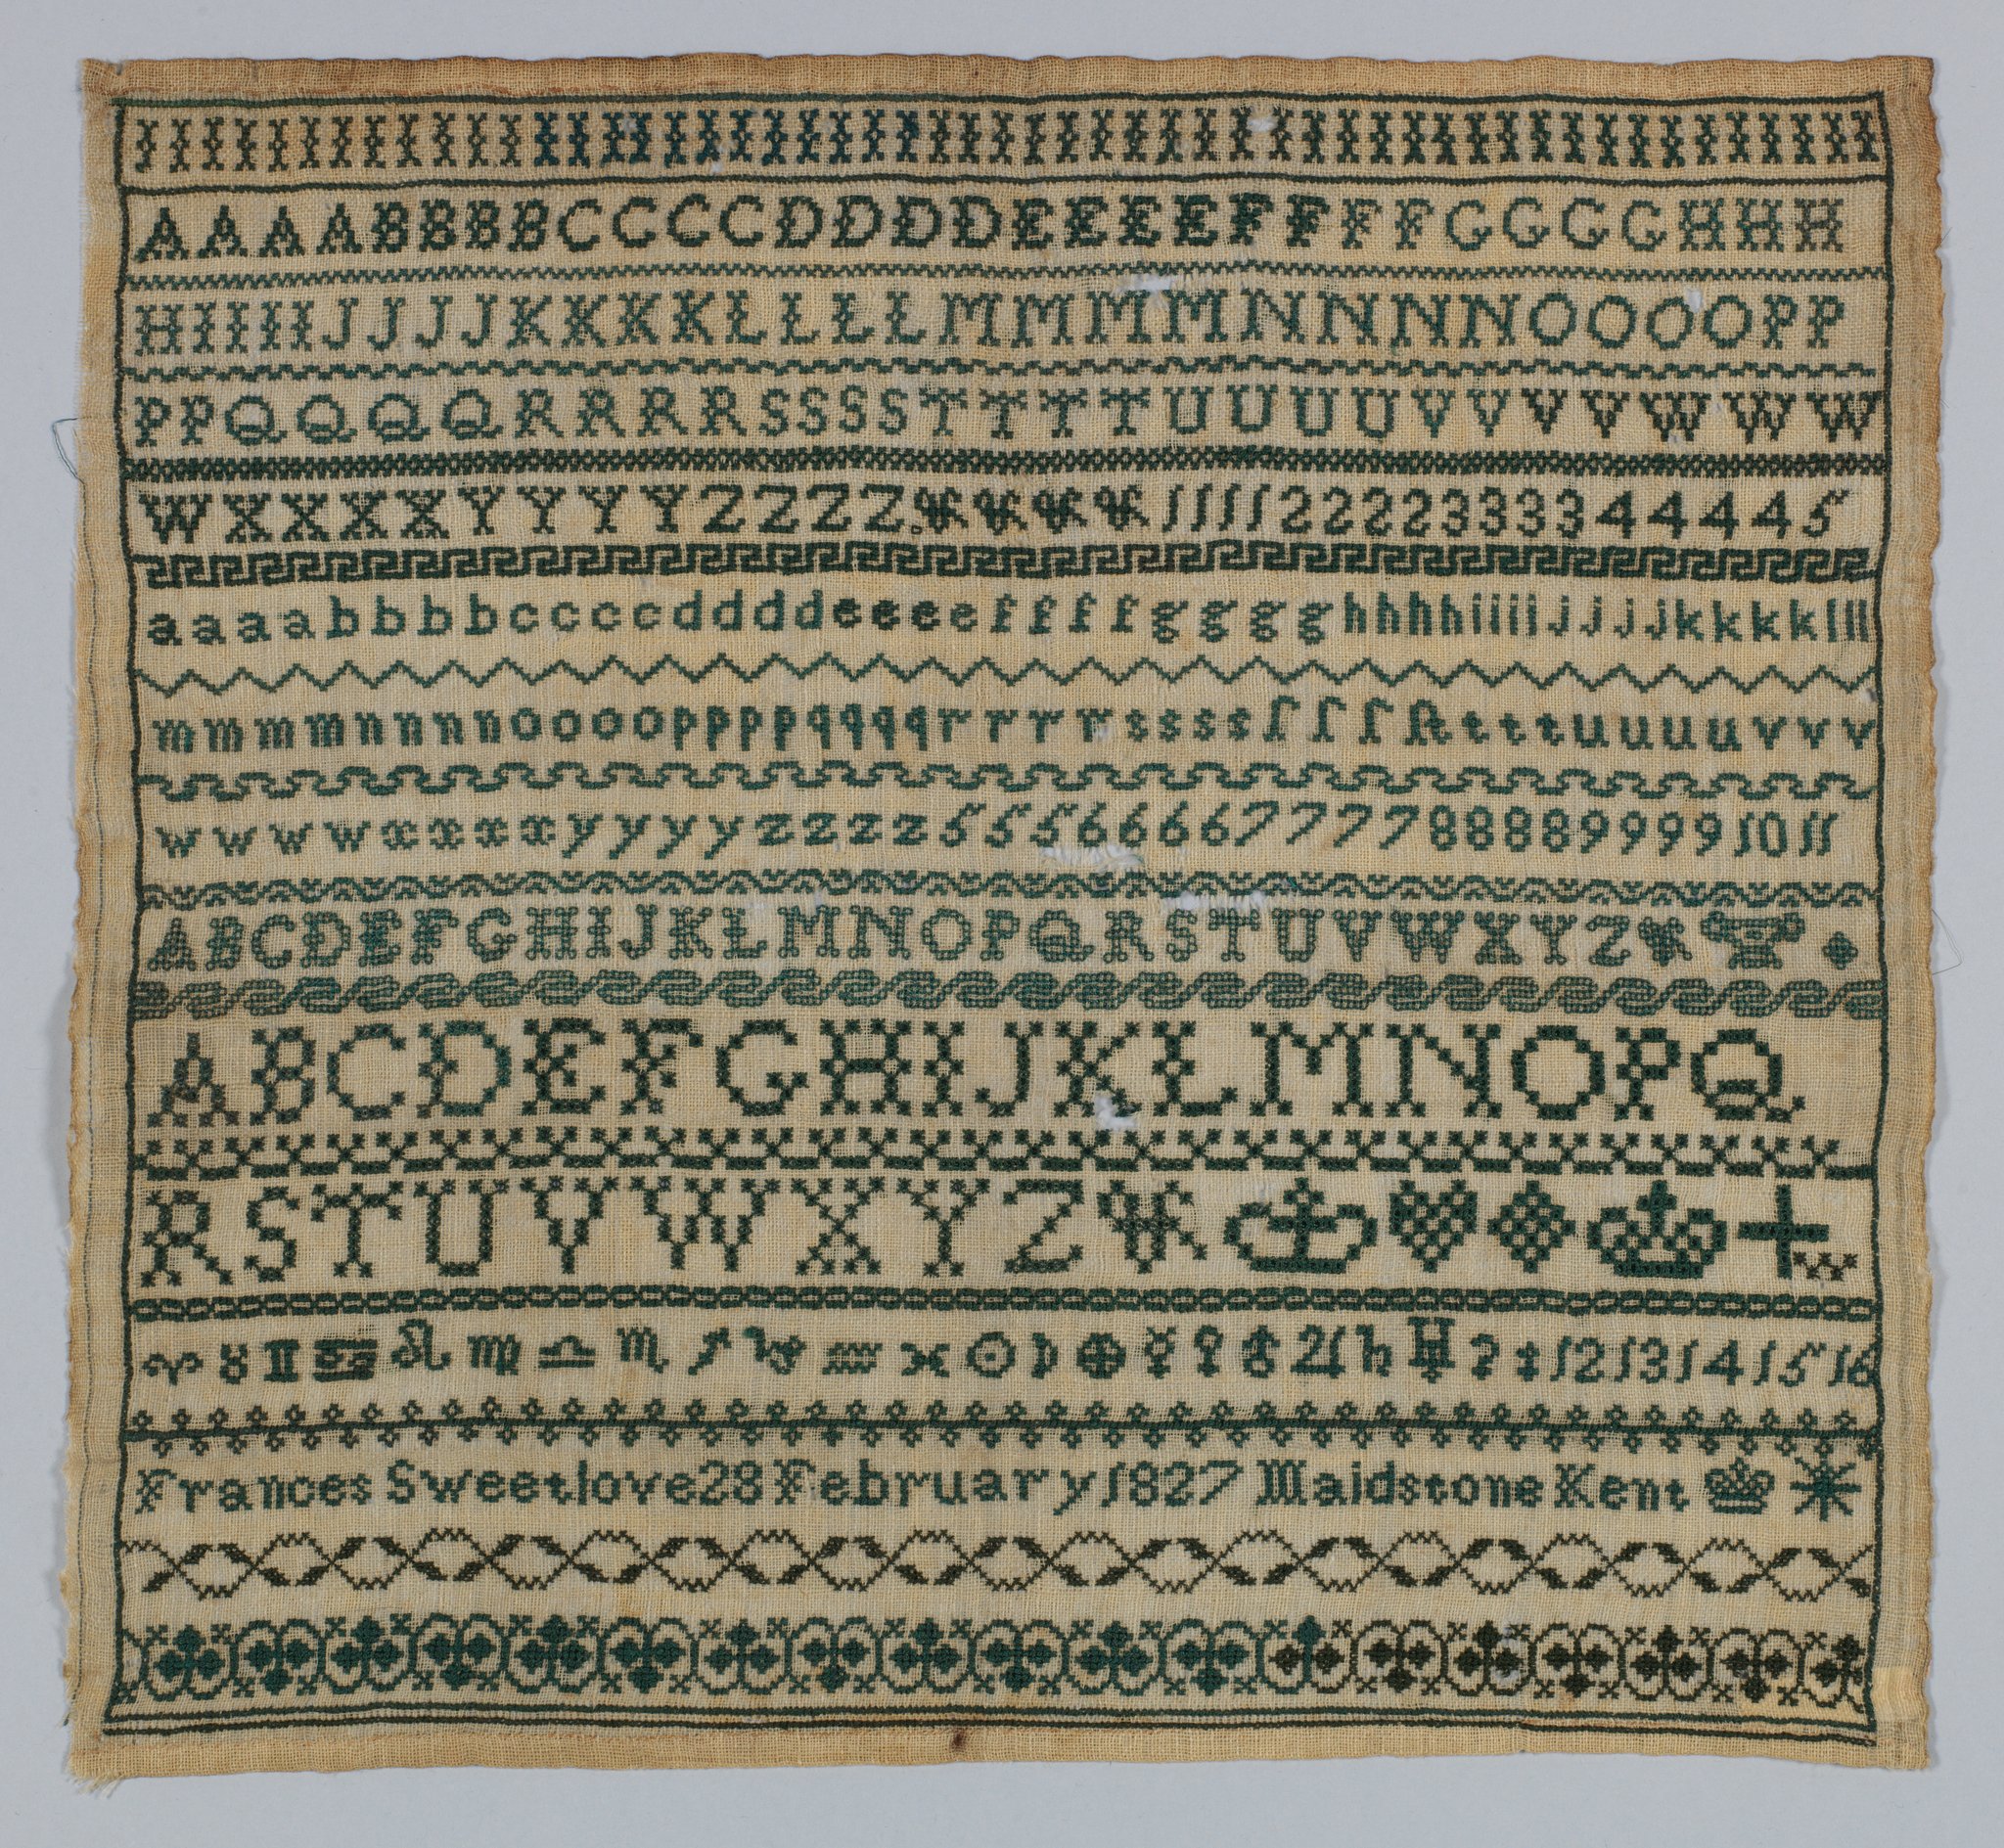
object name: sampler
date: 1827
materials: silk, wool